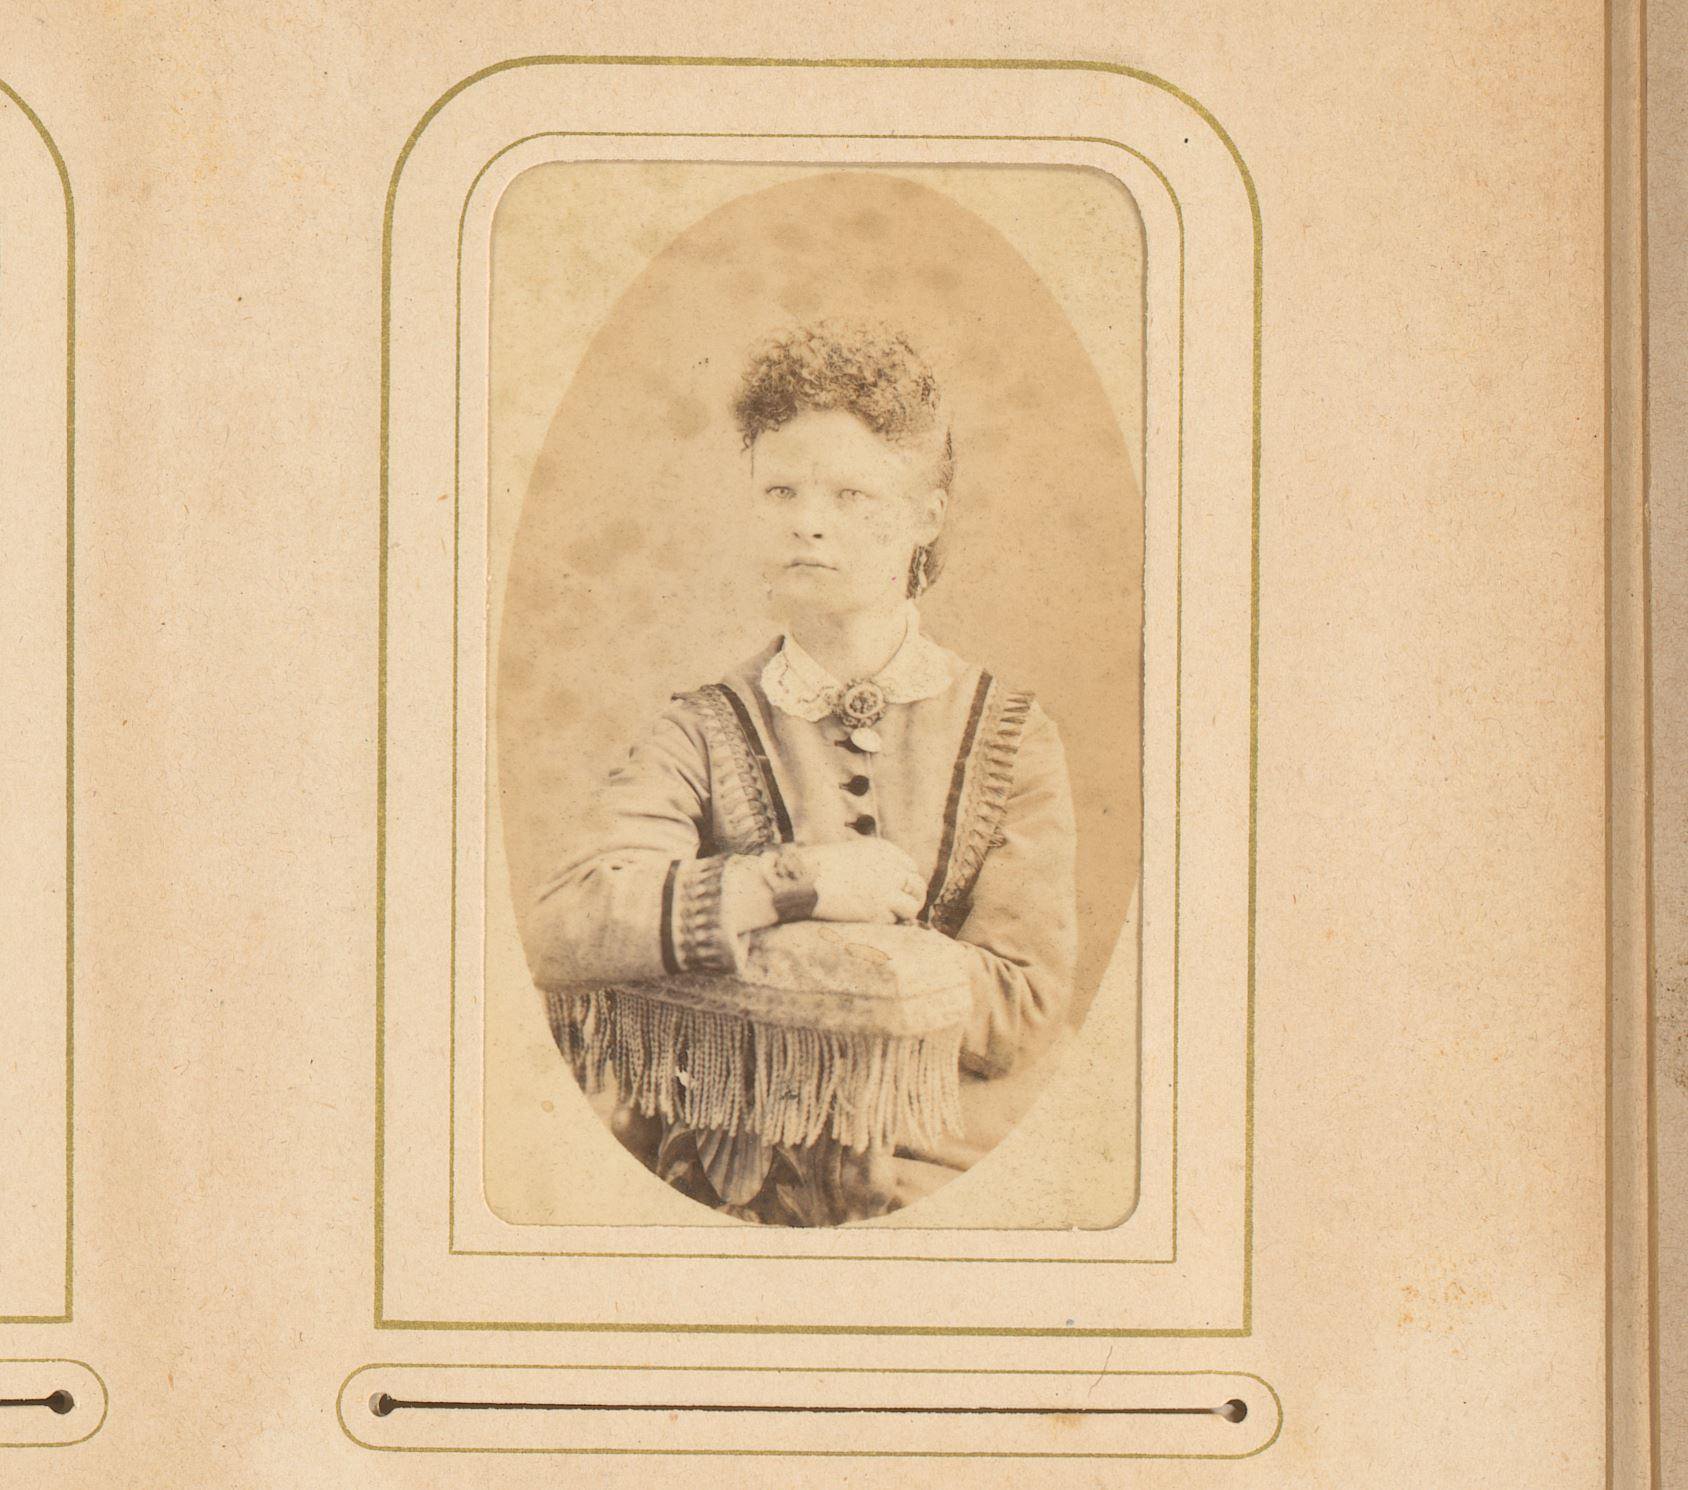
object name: carte de visite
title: Portret van een zittende vrouw, leunend op de leuning van een stoel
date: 1860-1900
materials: cardboard, photographic support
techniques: albumen print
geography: nieuwediep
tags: sitting figure - aa - female human figure, historical persons - bb - woman, chair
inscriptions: inscription: ‘Photographisch/ Atelier/ A.C. Weijens/ Nieuwediep.’